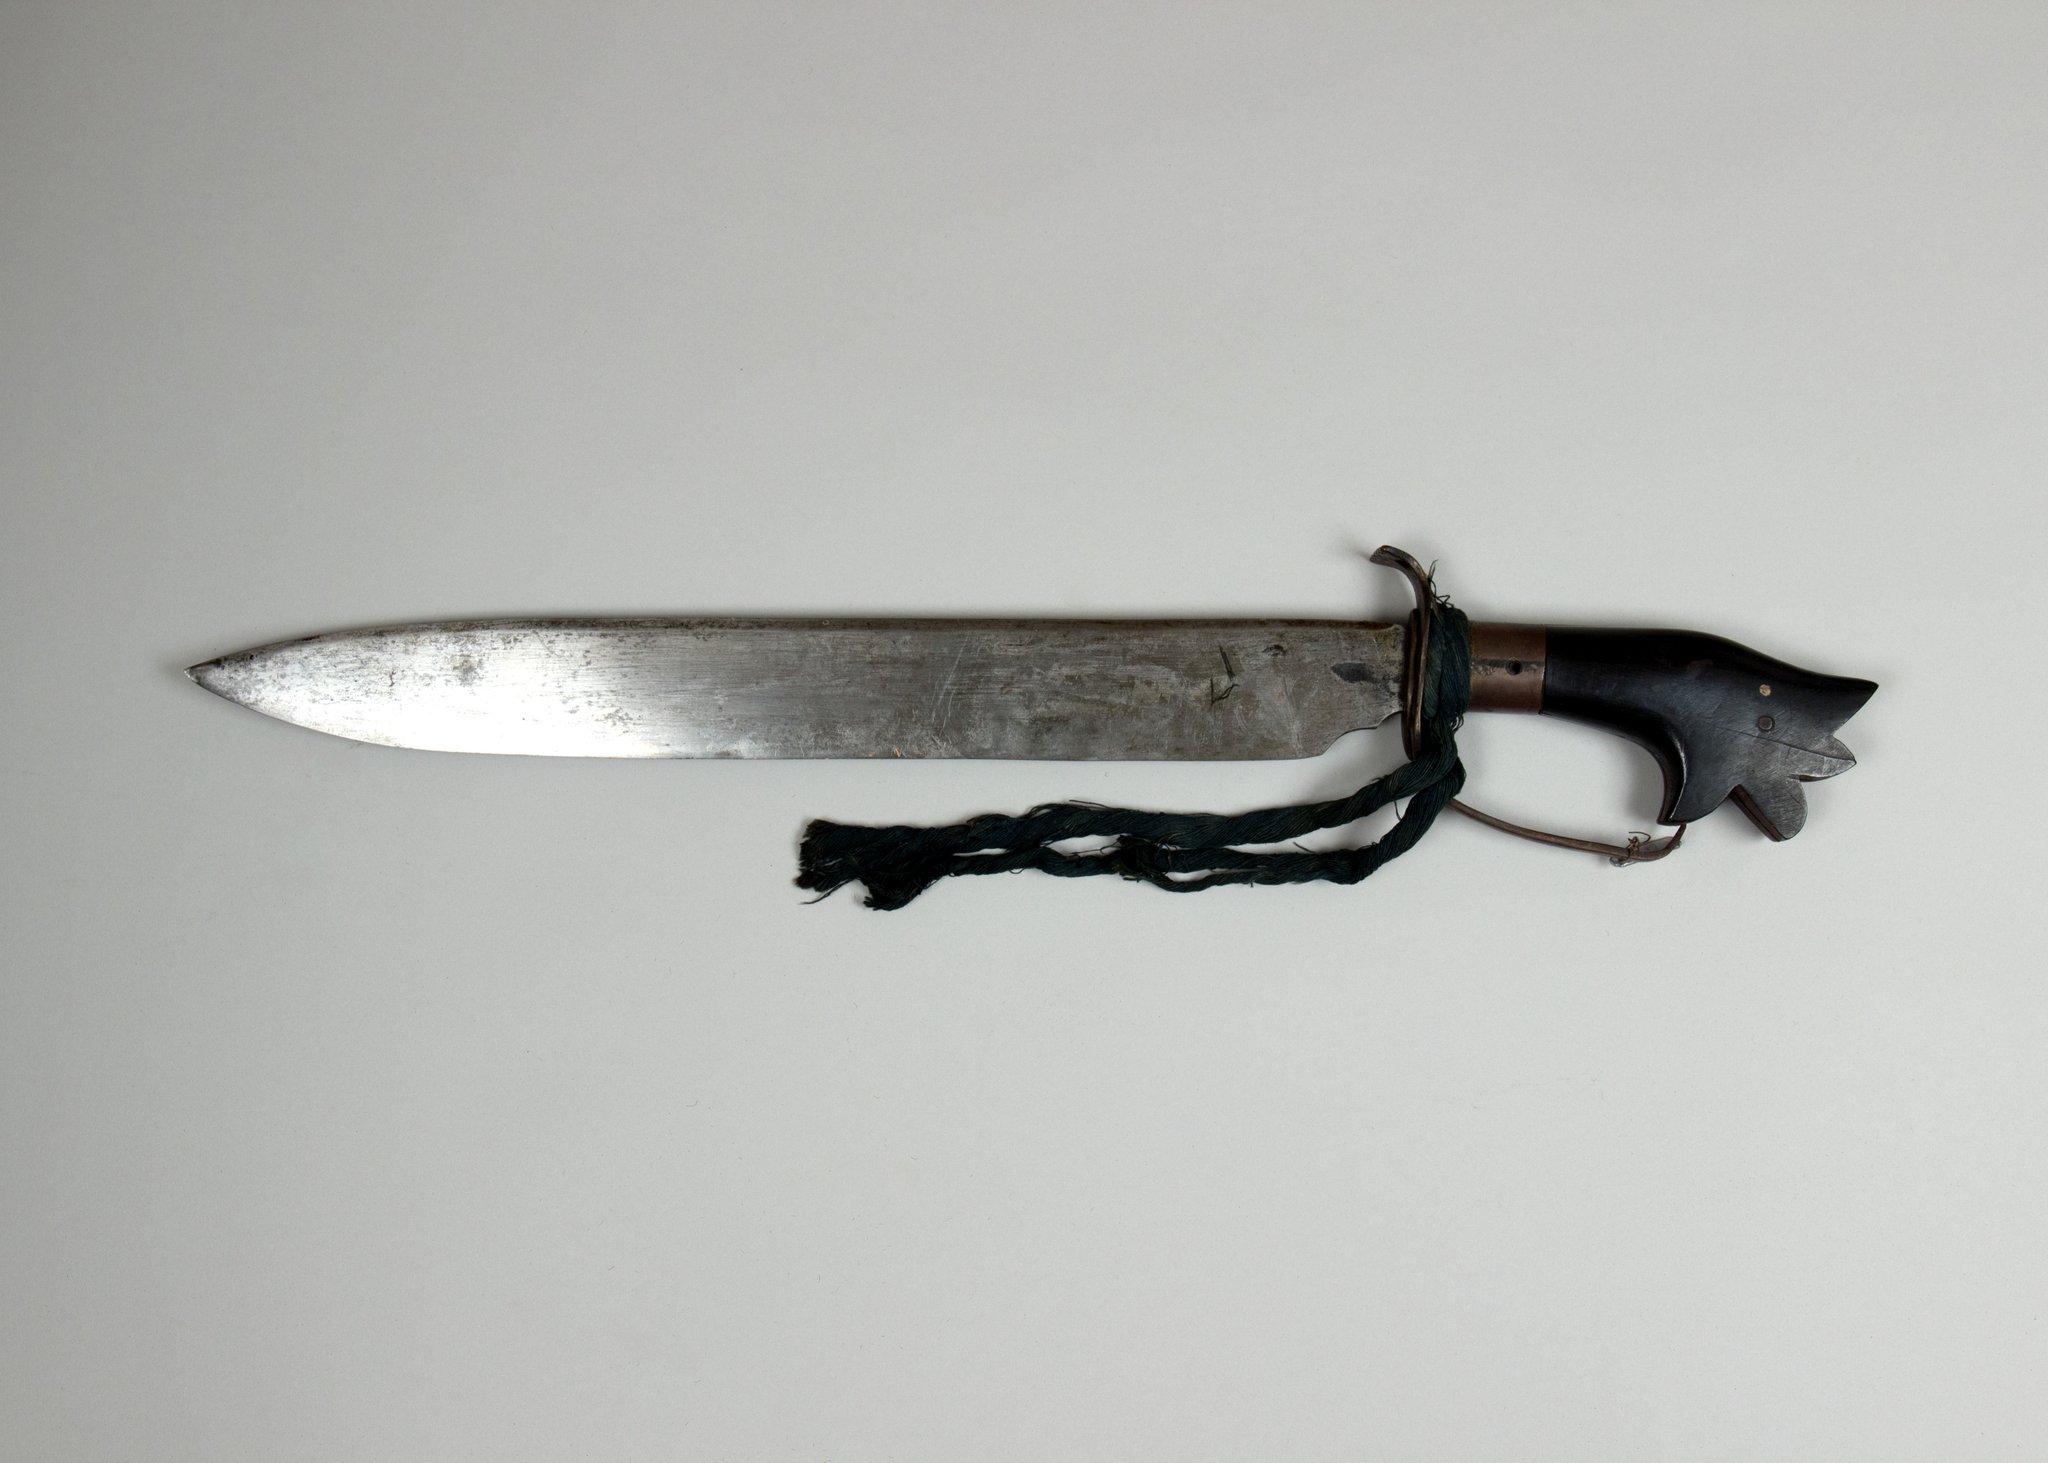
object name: knife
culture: philippine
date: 1701-1900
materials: brass, horn, steel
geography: philippines